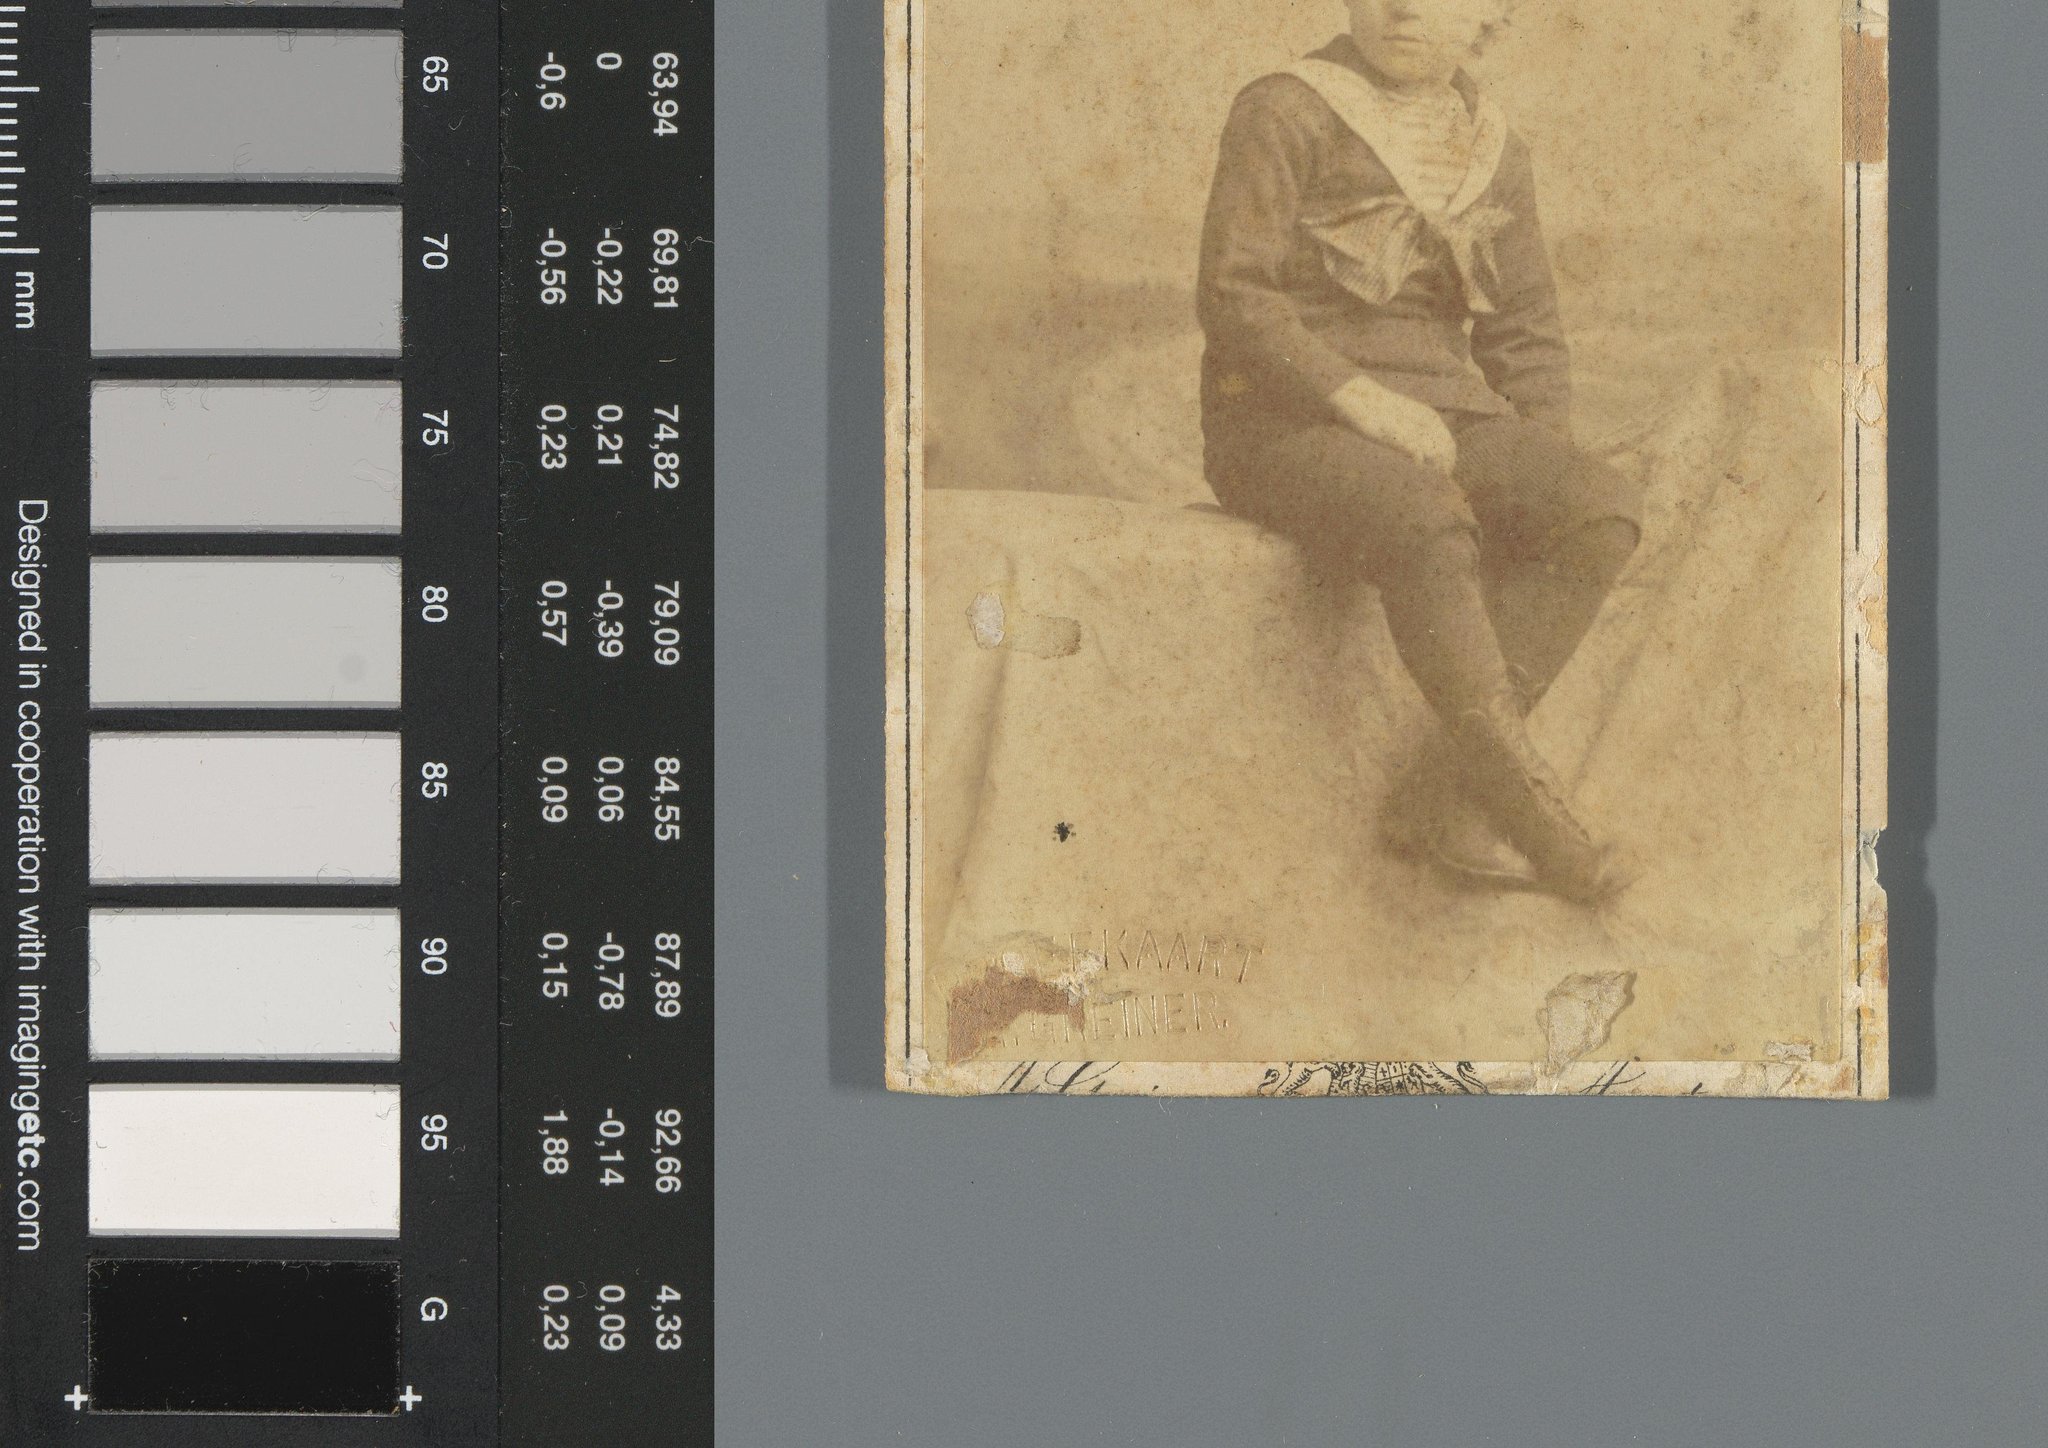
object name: photograph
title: Portret van Stephen Willem de Clercq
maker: albert greiner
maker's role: fotograaf, fotostudio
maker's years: 1833-1890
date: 1882-1885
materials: cardboard, photographic support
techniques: photography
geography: amsterdam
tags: historical persons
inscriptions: annotation: ‘S.Willem de Clercq Jr.’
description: Portret van Stephen Willem de Clercq, als kind, zittend op een verhoging. Zie ook het tegelijkertijd gemaakte portret van zijn zus Goverta.